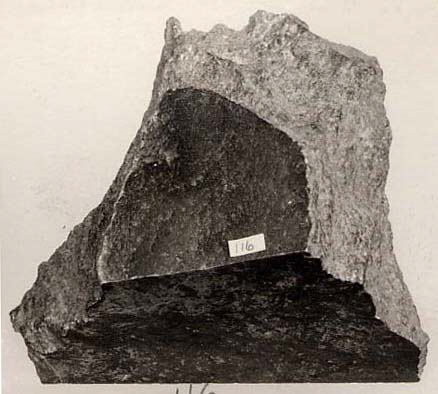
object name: fragment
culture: russian, siberia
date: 1902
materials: jade